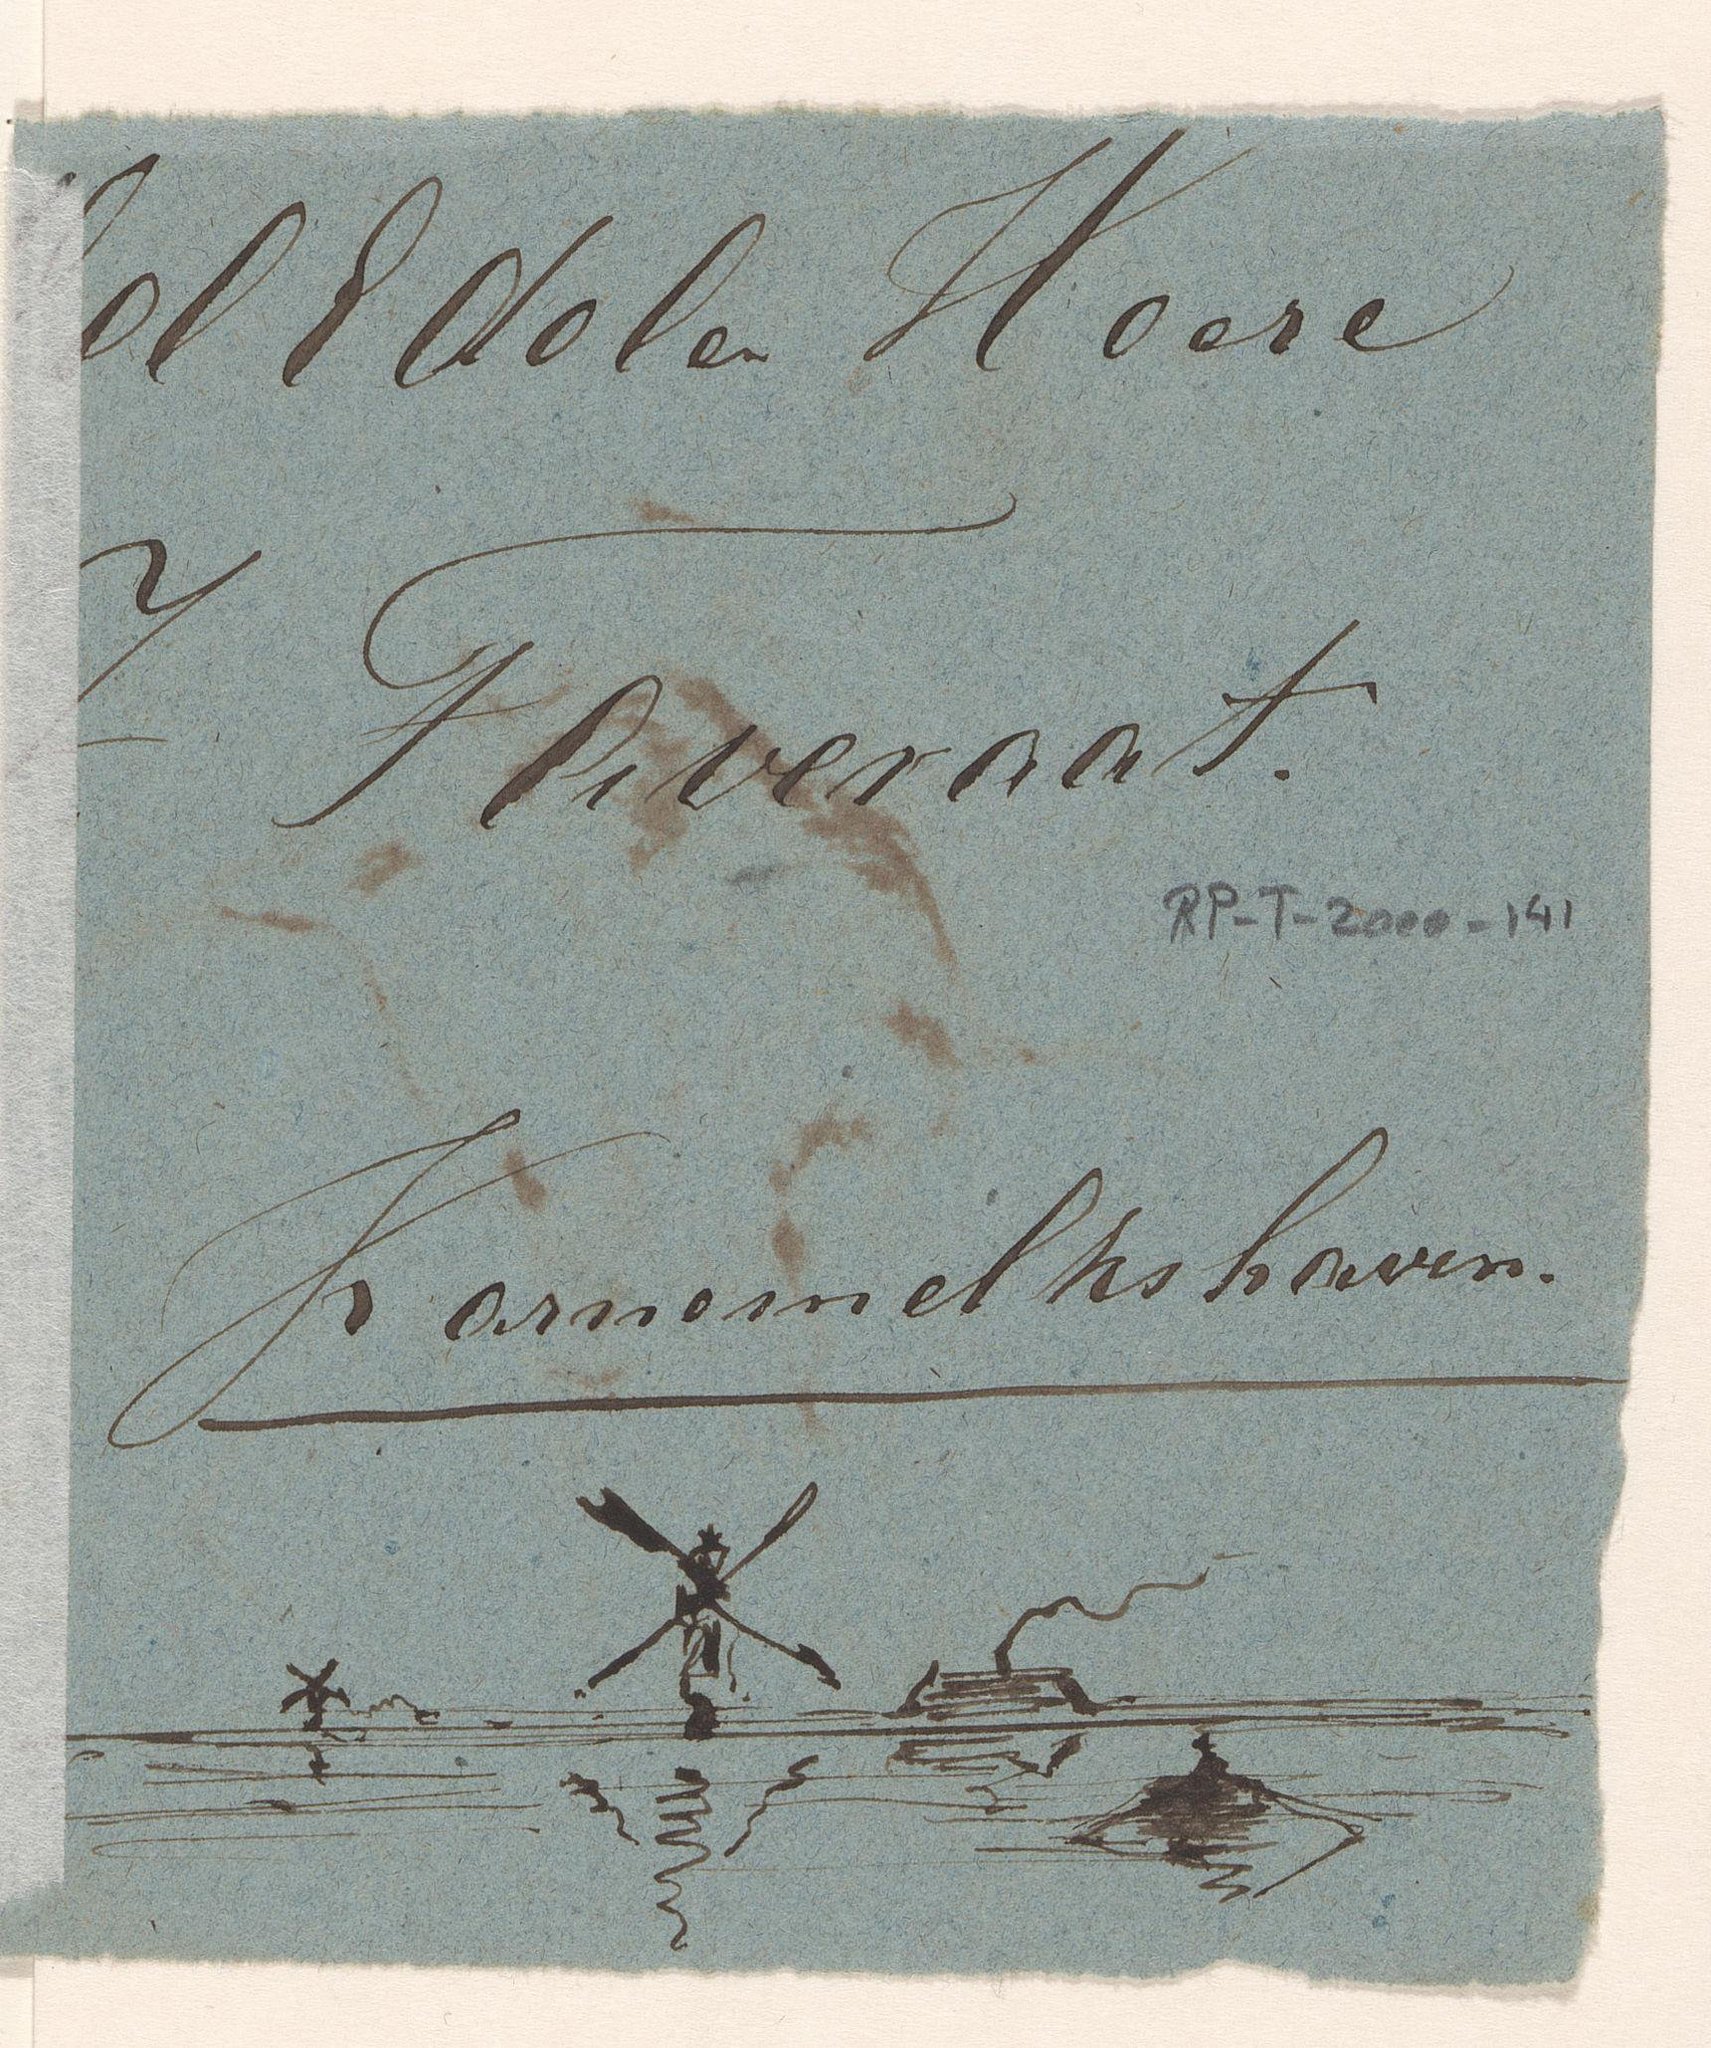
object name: drawing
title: Molentje aan het water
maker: johannes tavenraat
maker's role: draughtsman, painter, print maker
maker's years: 1809-1881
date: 1840-1870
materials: ink, paper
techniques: pen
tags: rotterdam, painter, print maker, draughtsman, johannes tavenraat, windmill in landscape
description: Schets van een molen aan het water, op een fragment van een geadresseerde envelop.